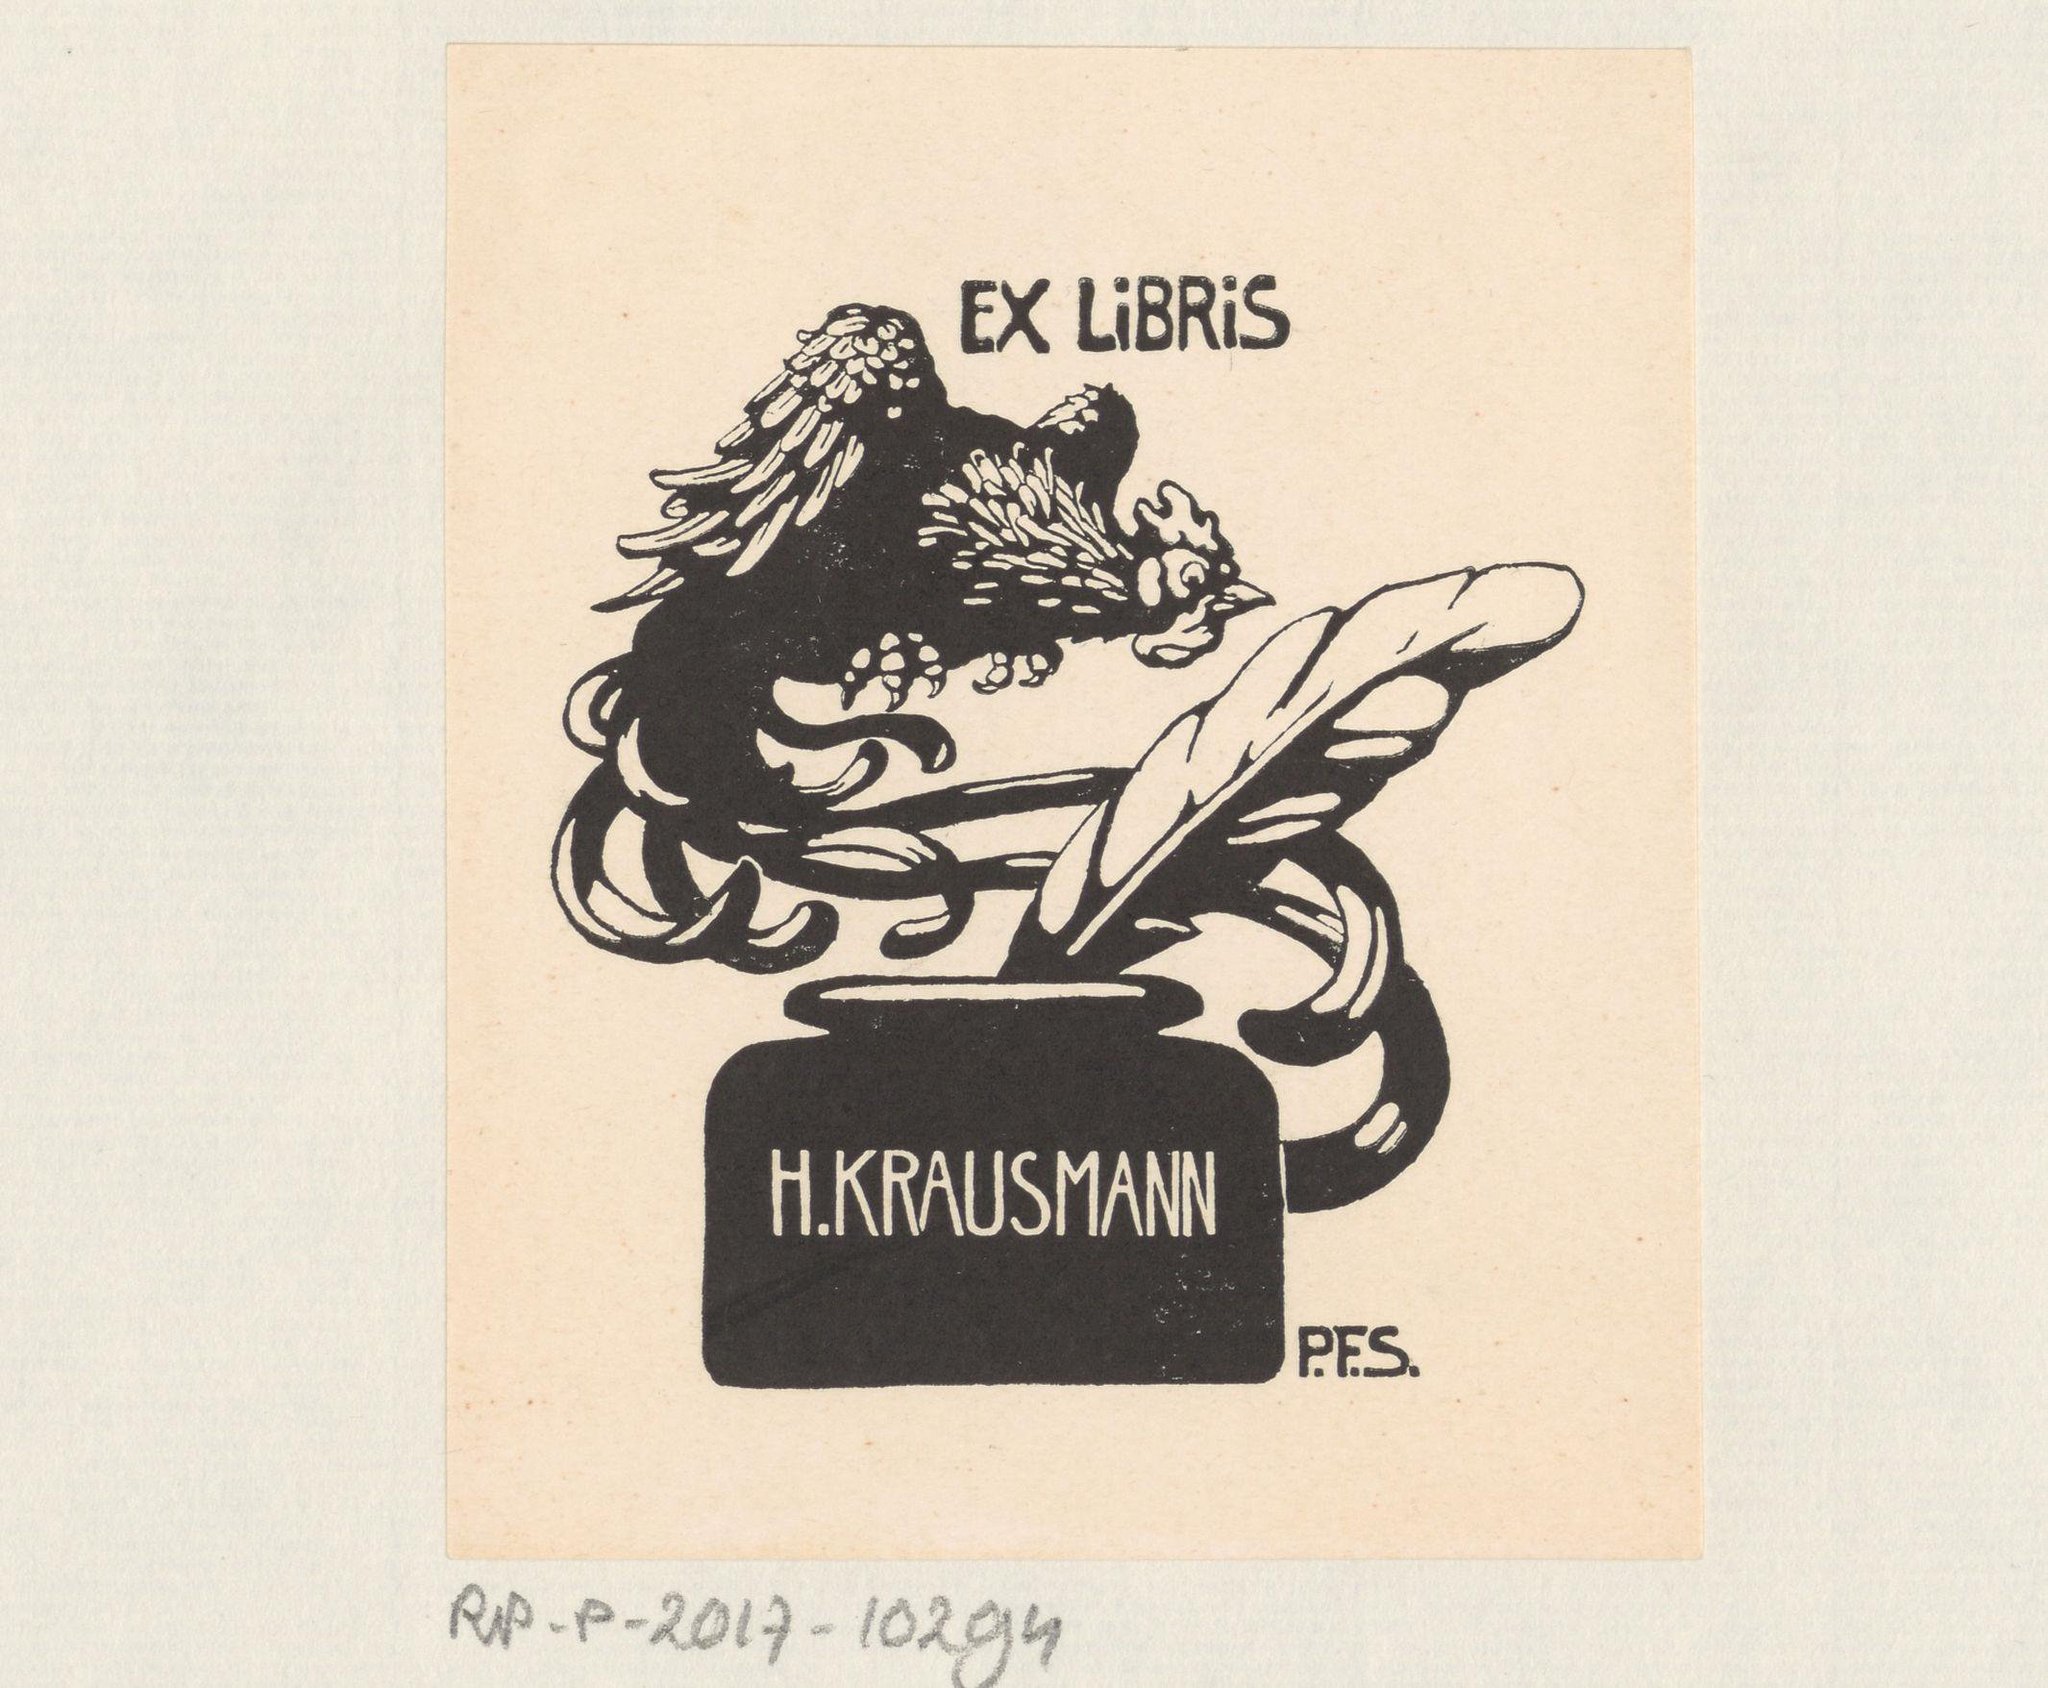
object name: bookplate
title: Ex libris van H. Krausmann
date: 1909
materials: paper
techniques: printing block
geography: germany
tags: quill, ink-well, fowl (cock, hen, chicken, etc.)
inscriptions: workshop stamp: ‘Ex libris H. Kraus-/ mann Karlsruhe, Baden,/ Kriegstr. 170 Entwurf von/ P.F. Scheel, Rostock, 1909’